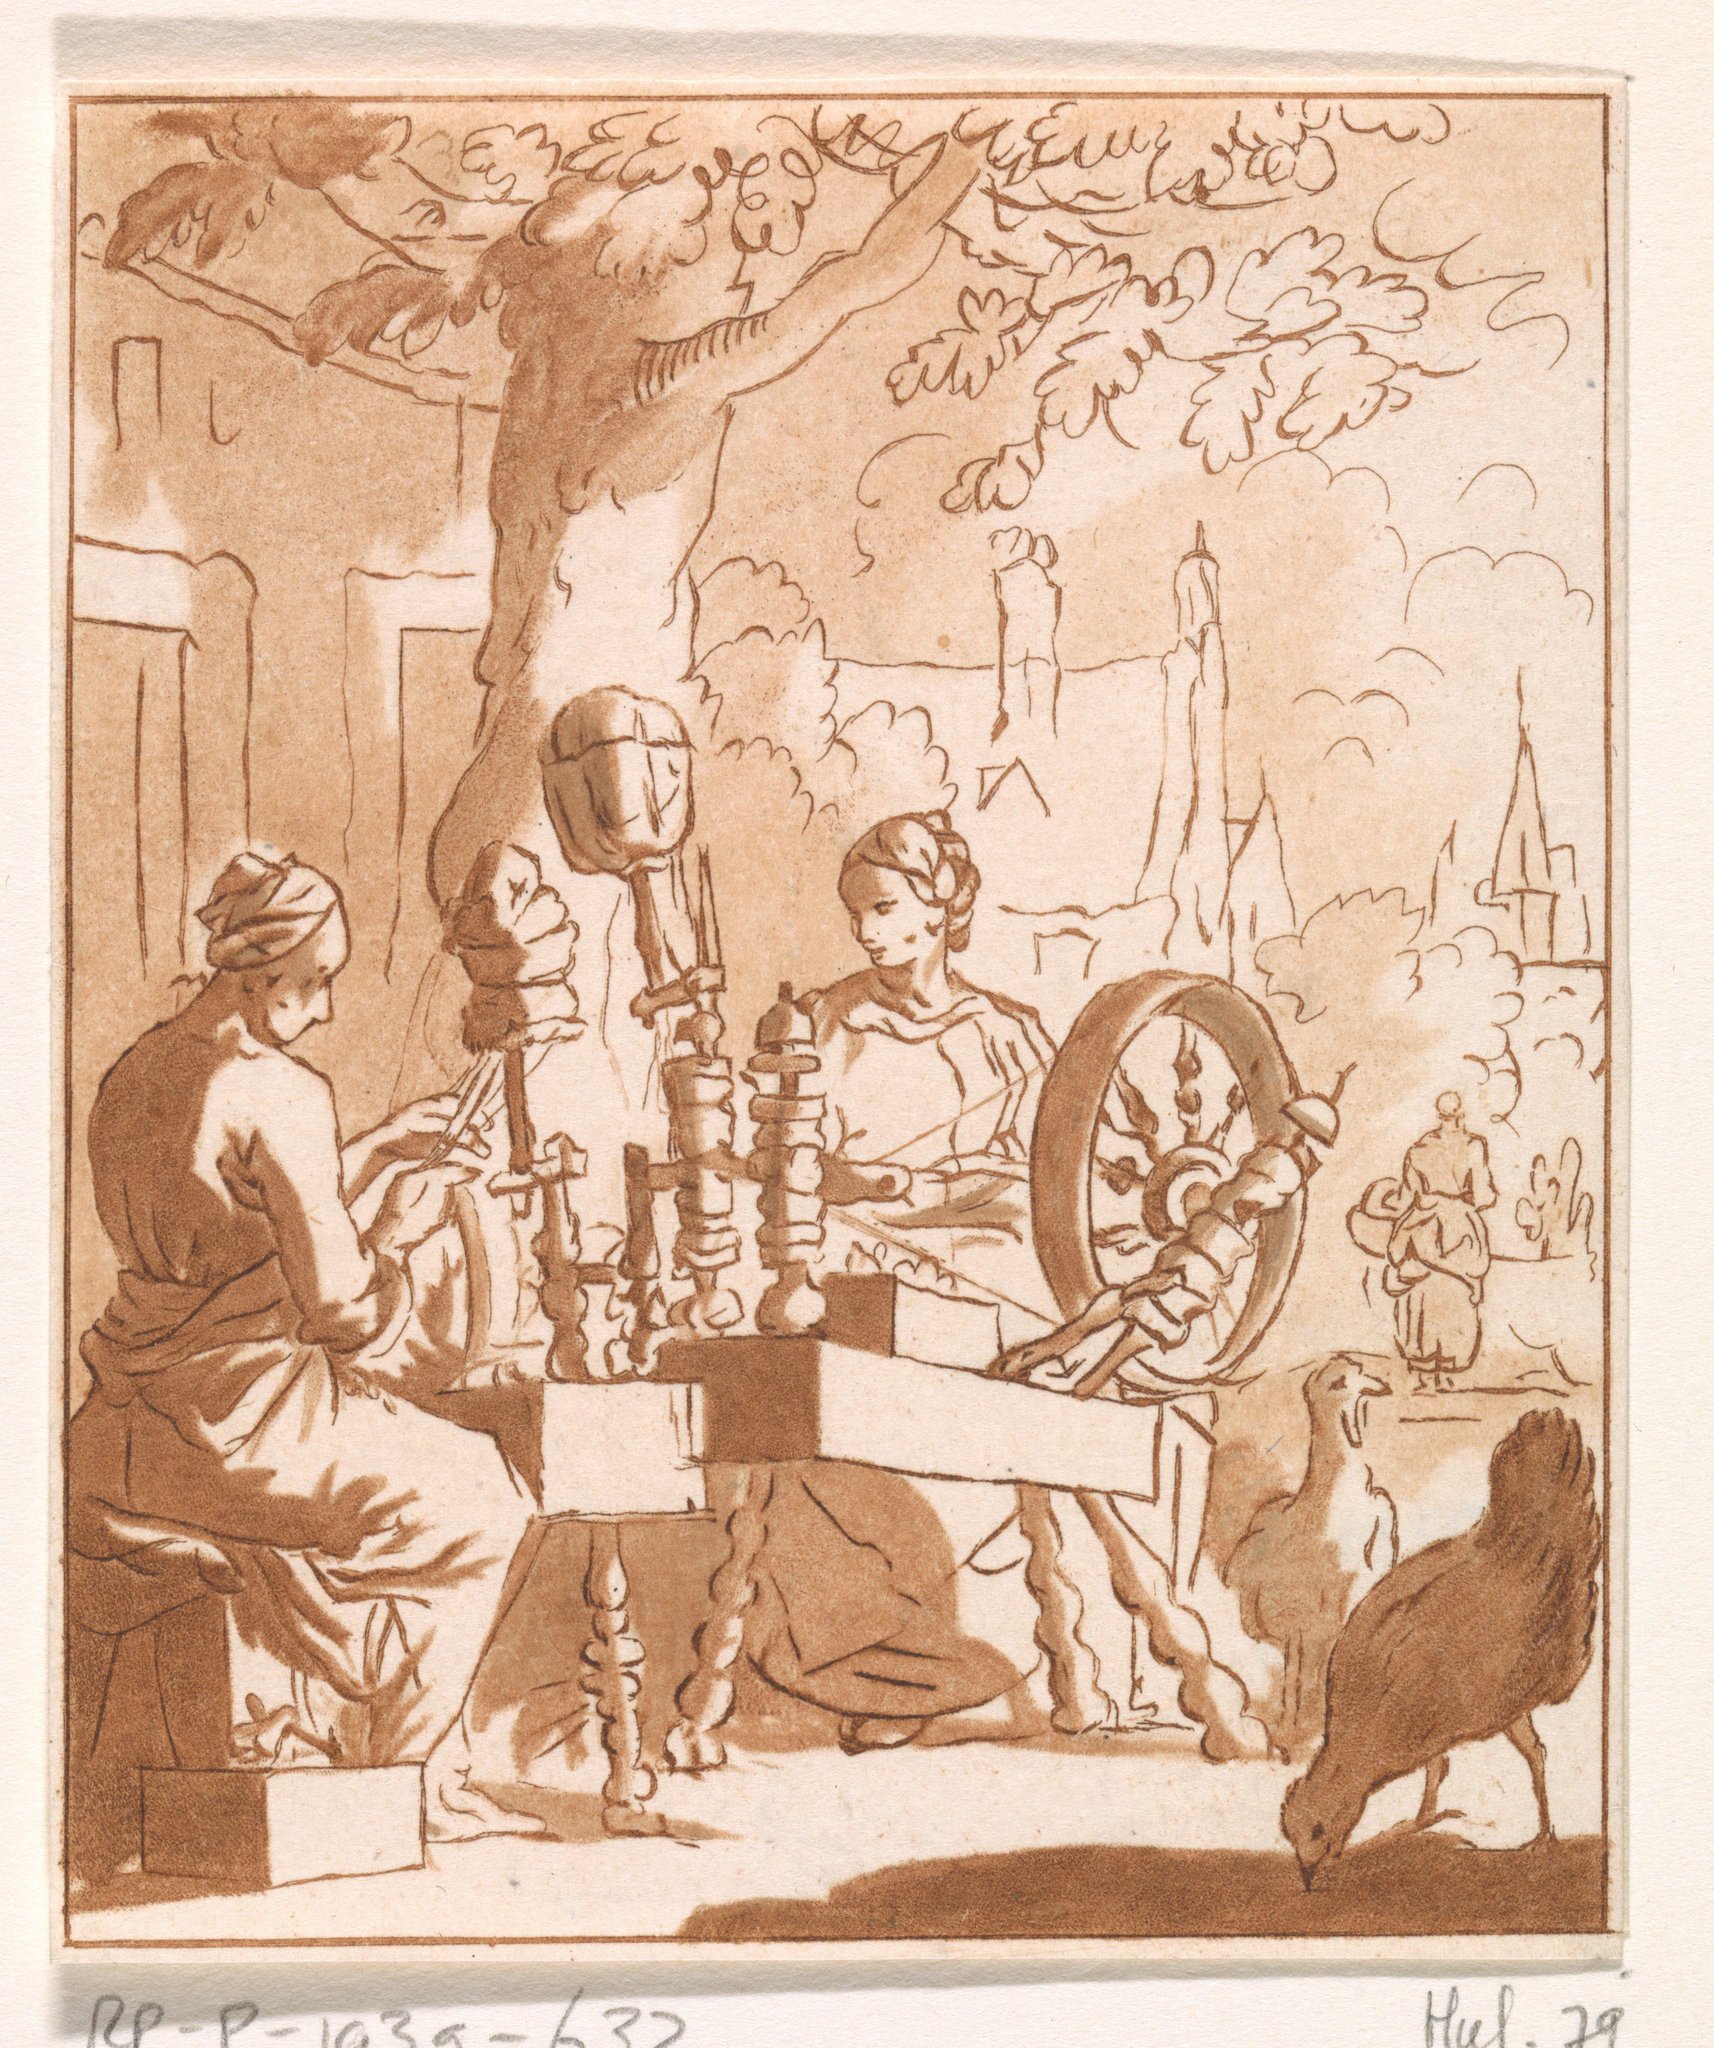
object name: print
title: Spinnende vrouwen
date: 1740-1780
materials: paper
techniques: print drawing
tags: spindle, fowl (cock, hen, chicken, etc.)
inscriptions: collector's mark: Lugt 2166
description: Onder een boom in een dorpstraat zitten twee vrouwen te spinnen. Op de voorgrond scharrelen twee kippen, en op de achtergrond zijn gebouwen te zien.